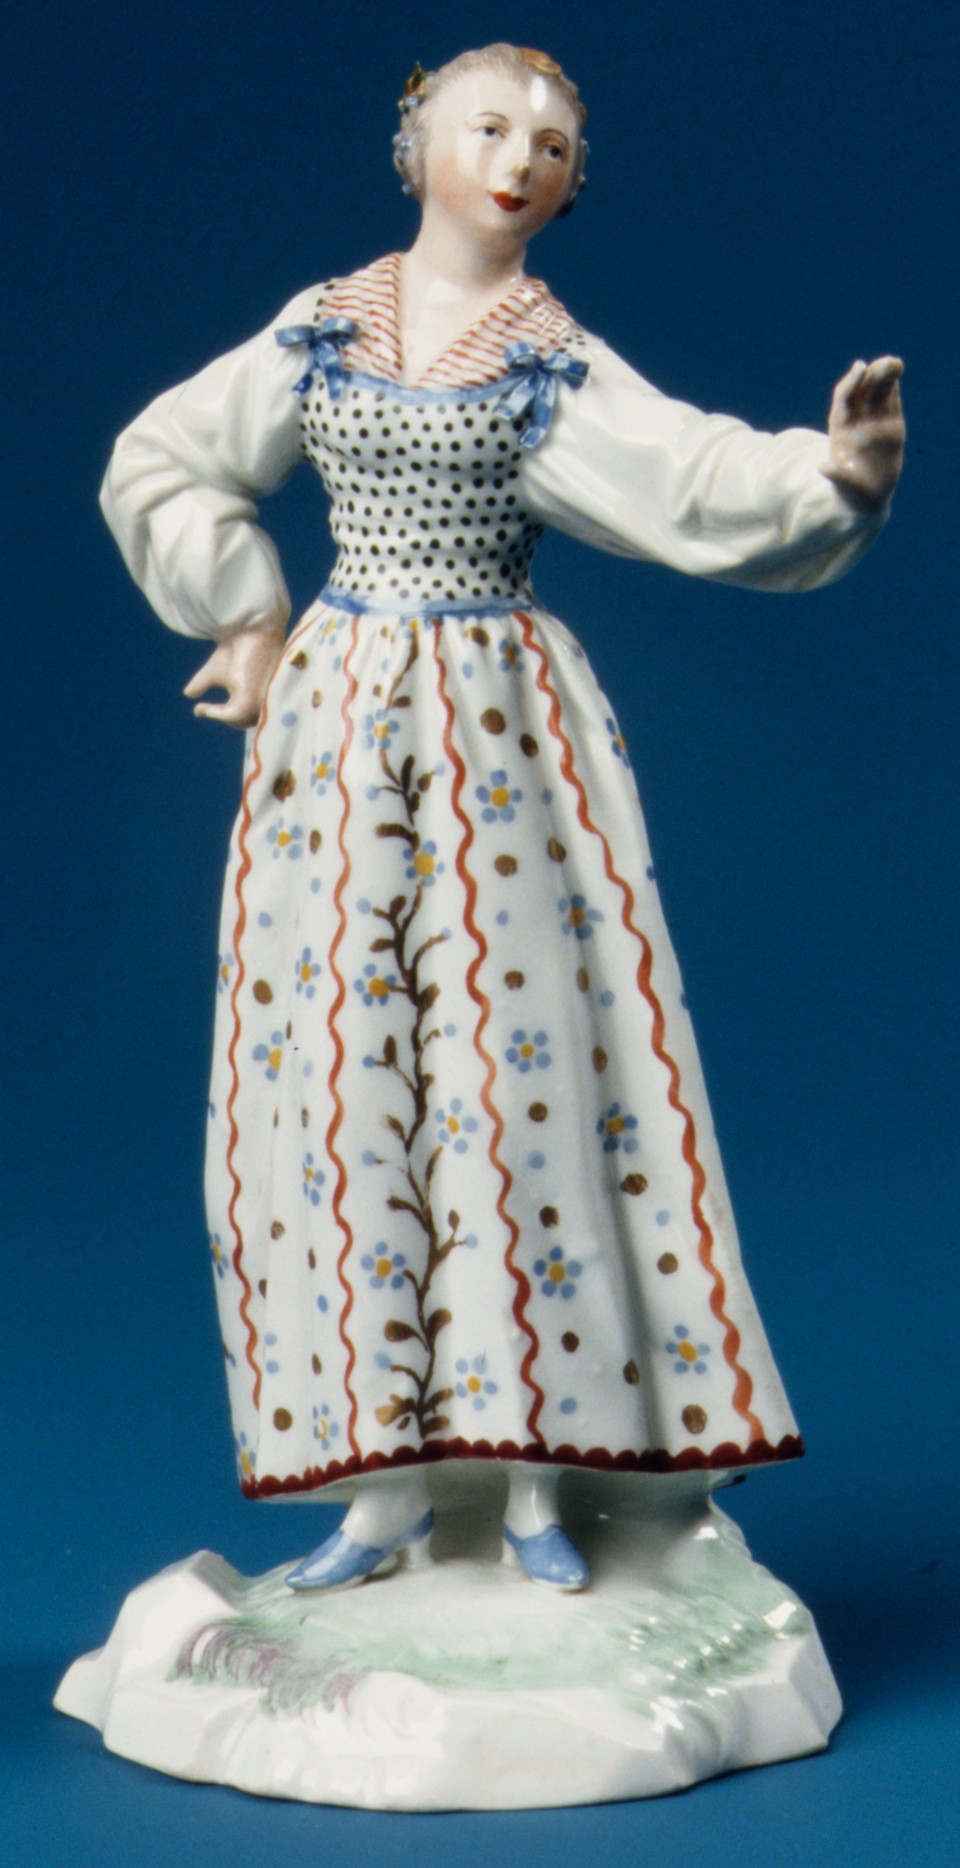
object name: figure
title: Columbine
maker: fulda pottery and porcelain manufactory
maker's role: manufactory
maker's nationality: german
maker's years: 1764-1789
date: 1770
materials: hard paste porcelain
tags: women